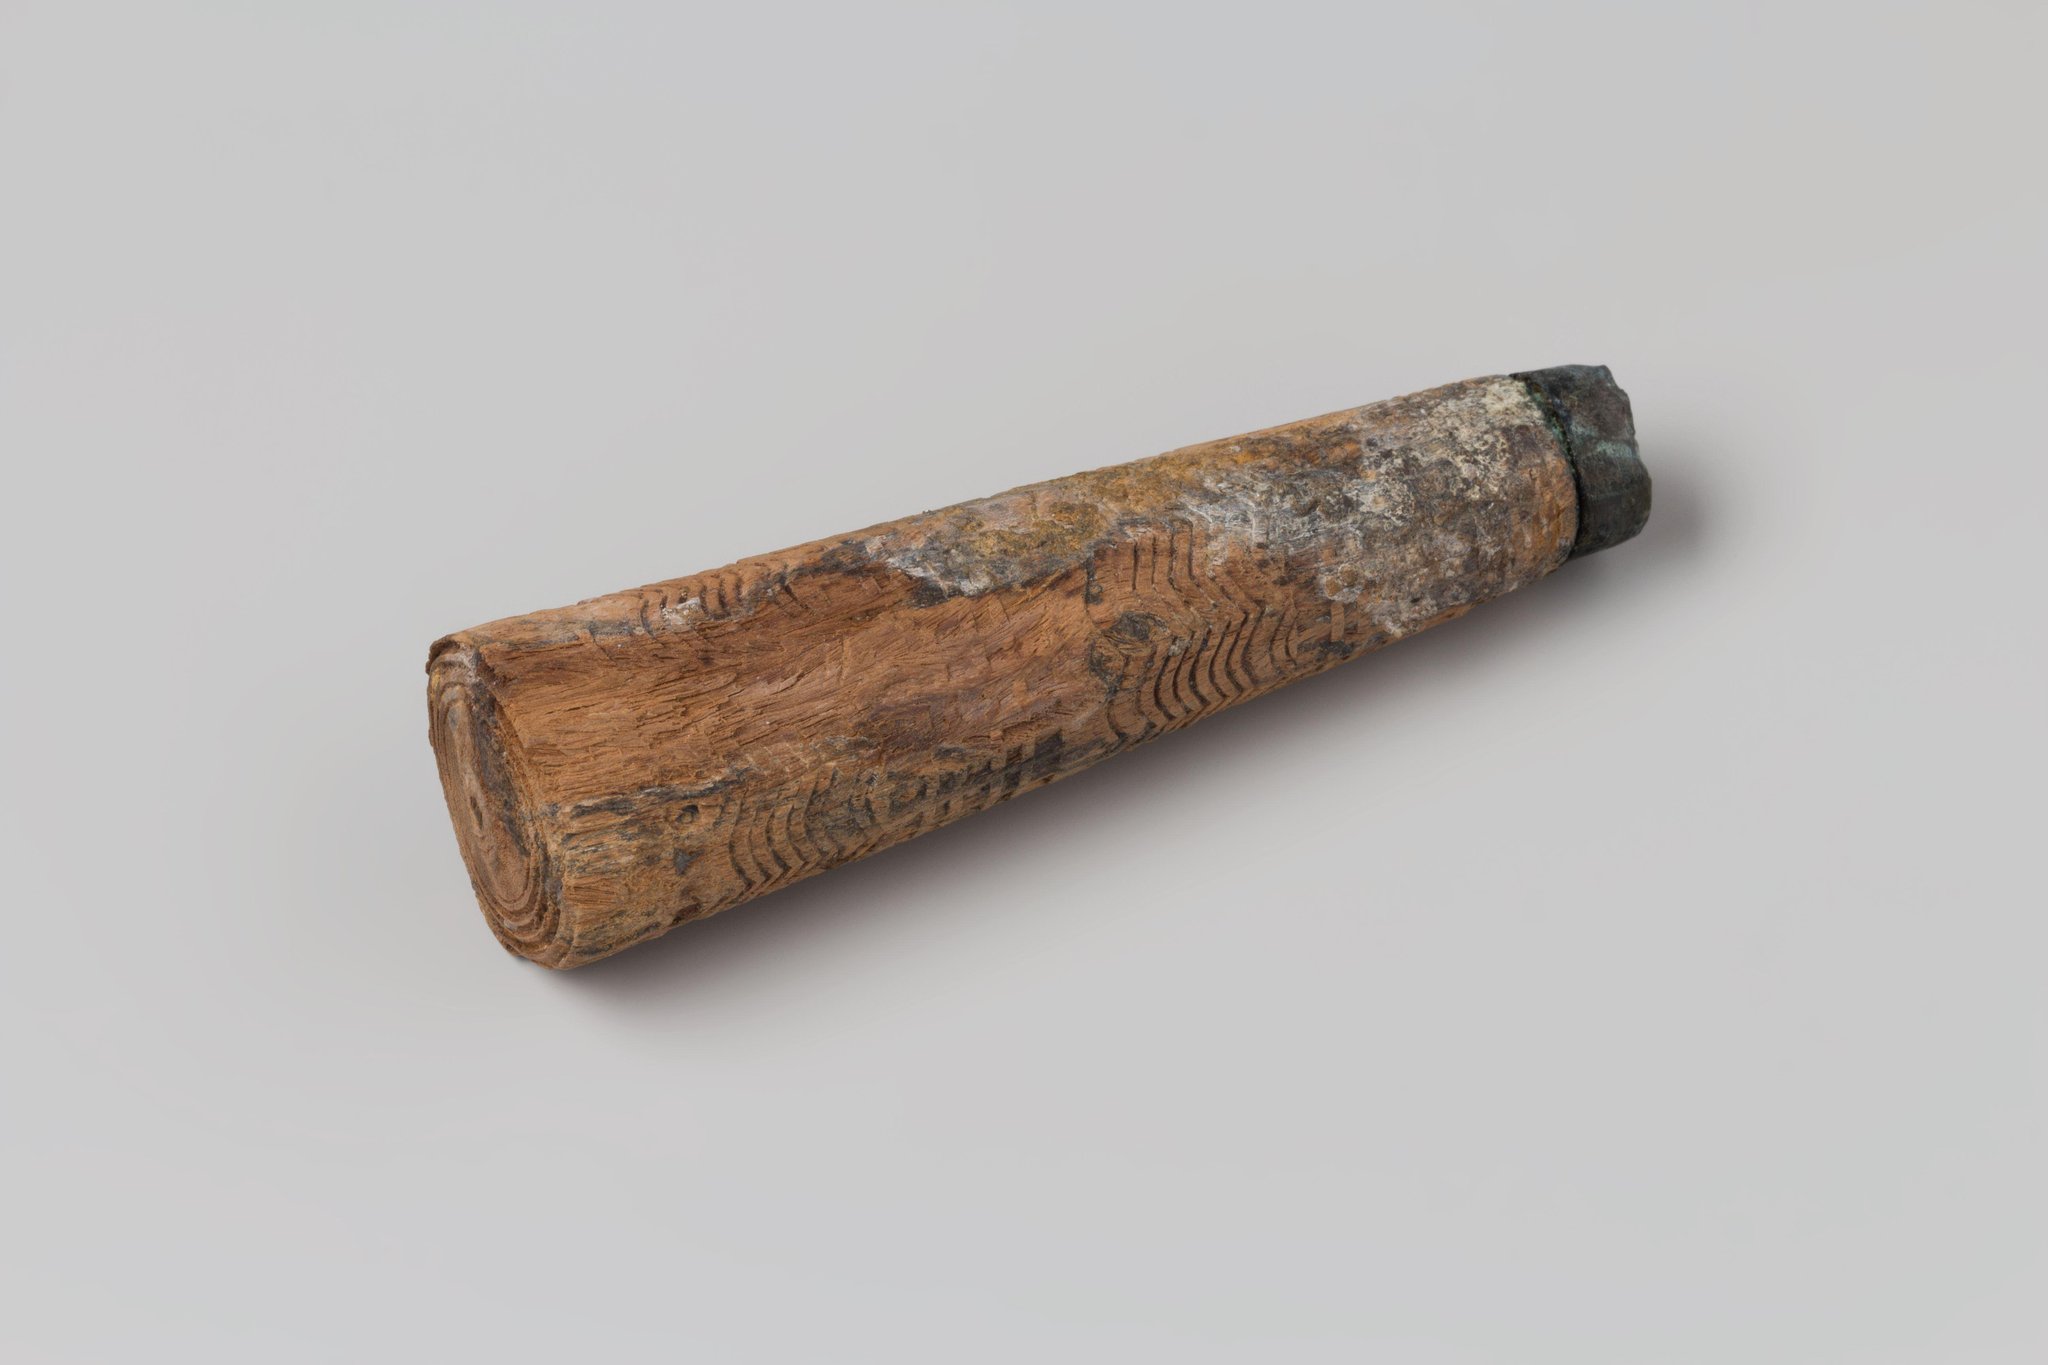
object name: knife handle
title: Messenheft uit het wrak van de Oost-Indiëvaarder Hollandia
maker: Anonymous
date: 1700-1743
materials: copper, wood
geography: netherlands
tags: verenigde oostindische compagnie, hollandia (schip), annet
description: Knife, handle, cylindrical: tapering; id. NG 1979-403H, ferrule, id. NG 1980-27H426.